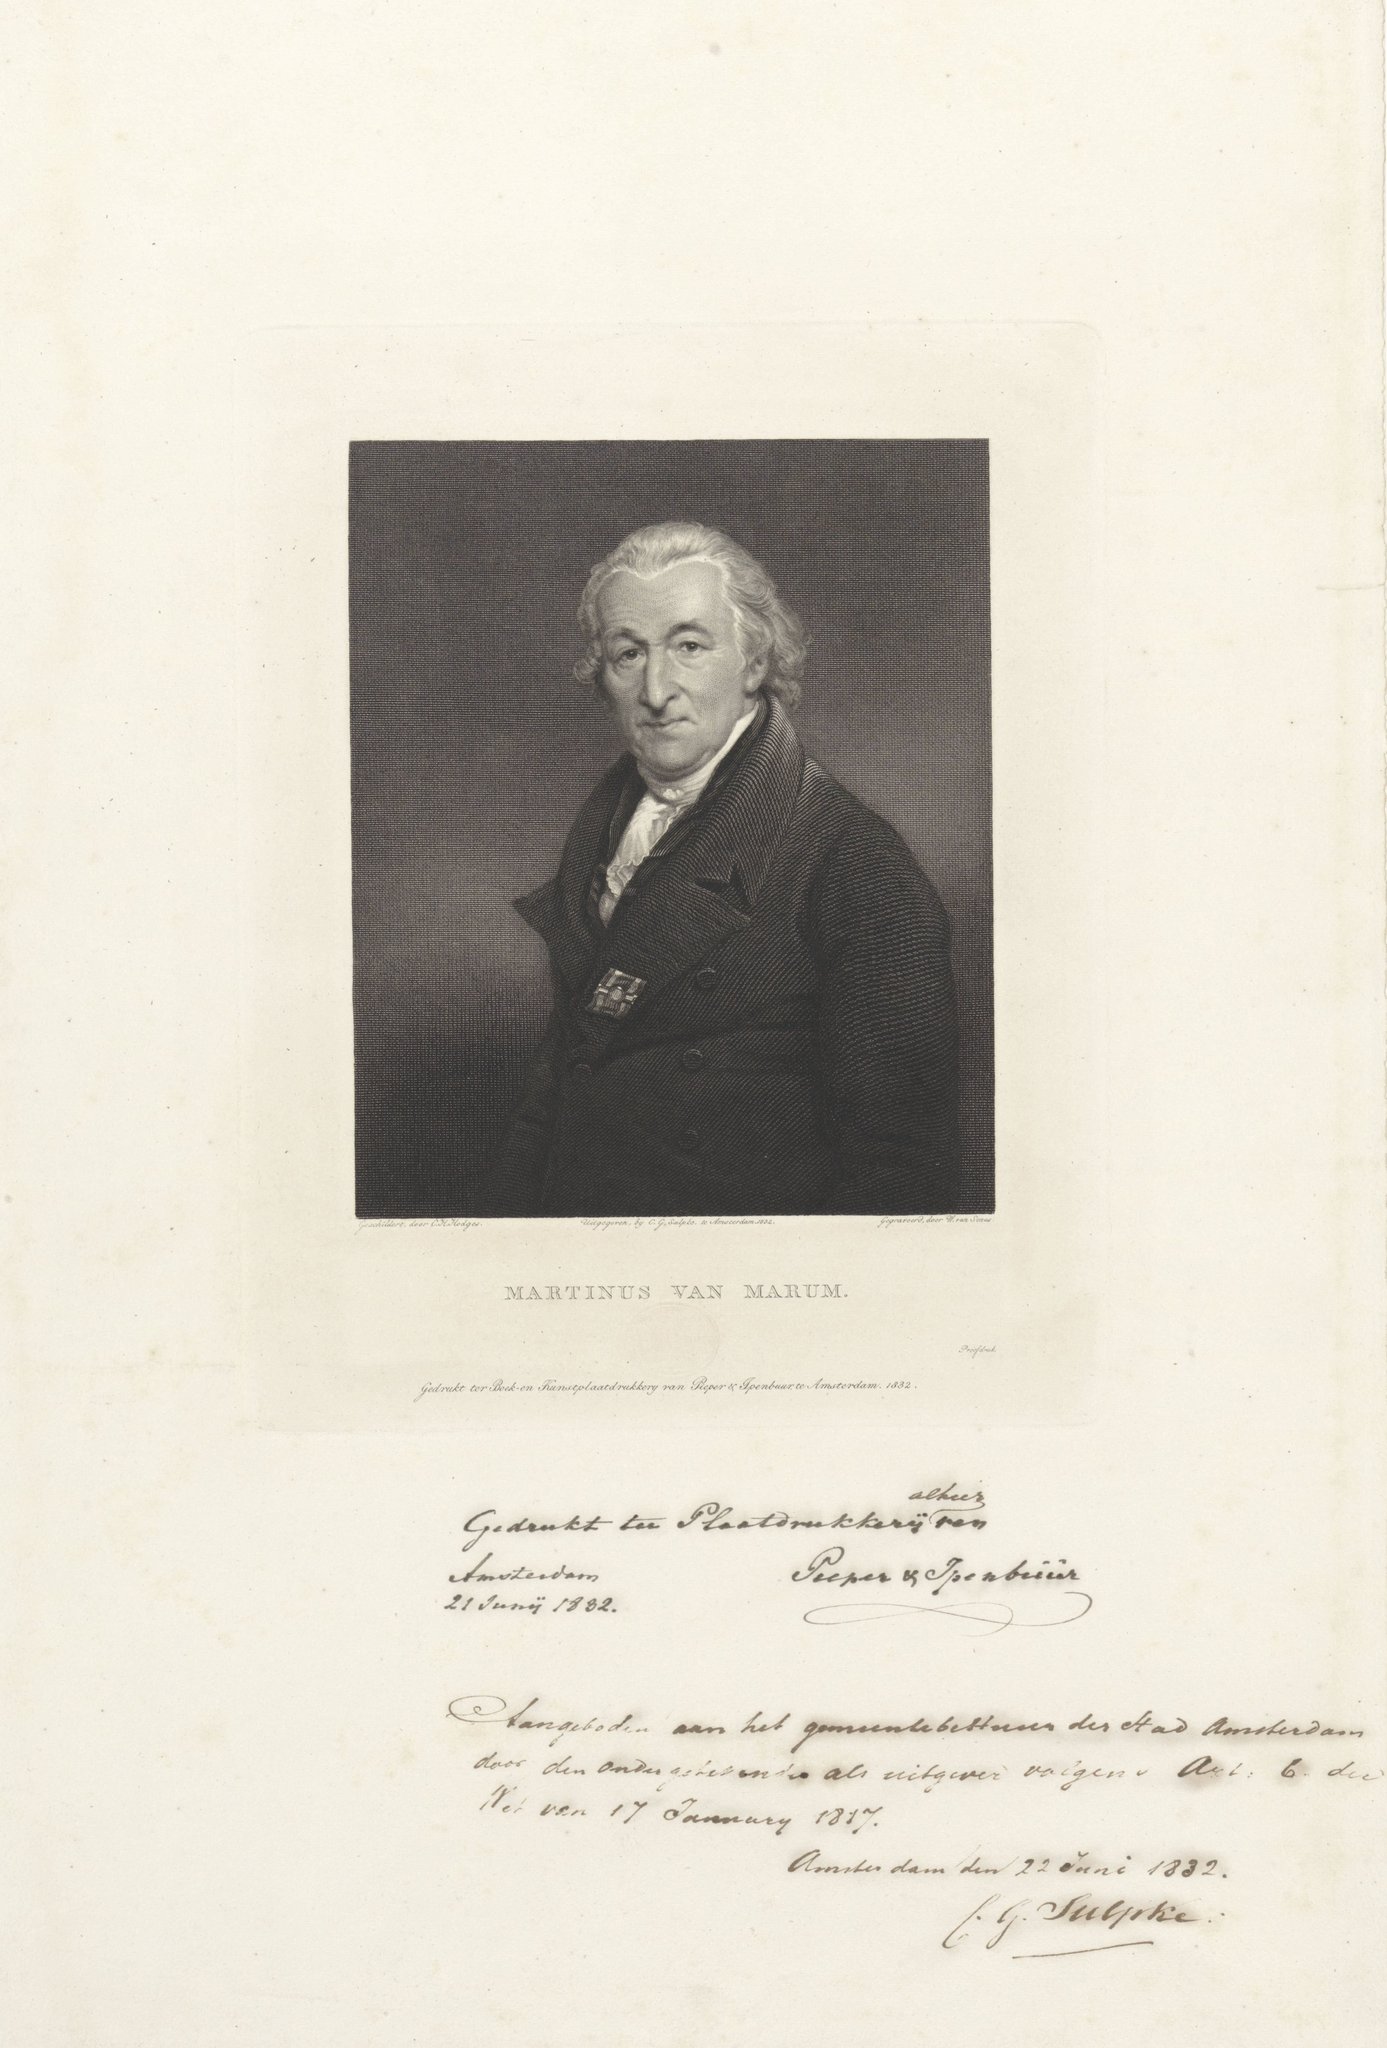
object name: print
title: Portret van Martinus van Marum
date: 1832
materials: ink, paper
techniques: engraving, etching, pen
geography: amsterdam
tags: delft, haarlem, physicist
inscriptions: collector's mark: Lugt 2228, stamp: ‘Bekroond door KN instituut vierde classe MDCCCXXXI’, inscription: ‘Aaangeboden aan hte gemeentebestuur der Stad Amsterdam/ door den ondergtekende als uitgever volgens Art. 6 die/ Wet van 17 January 1817./ Amsterdam den 22 Juni 1832/ C.G. Sulpke’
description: Portret van de schei- en natuurkundige Martinus van Marum.